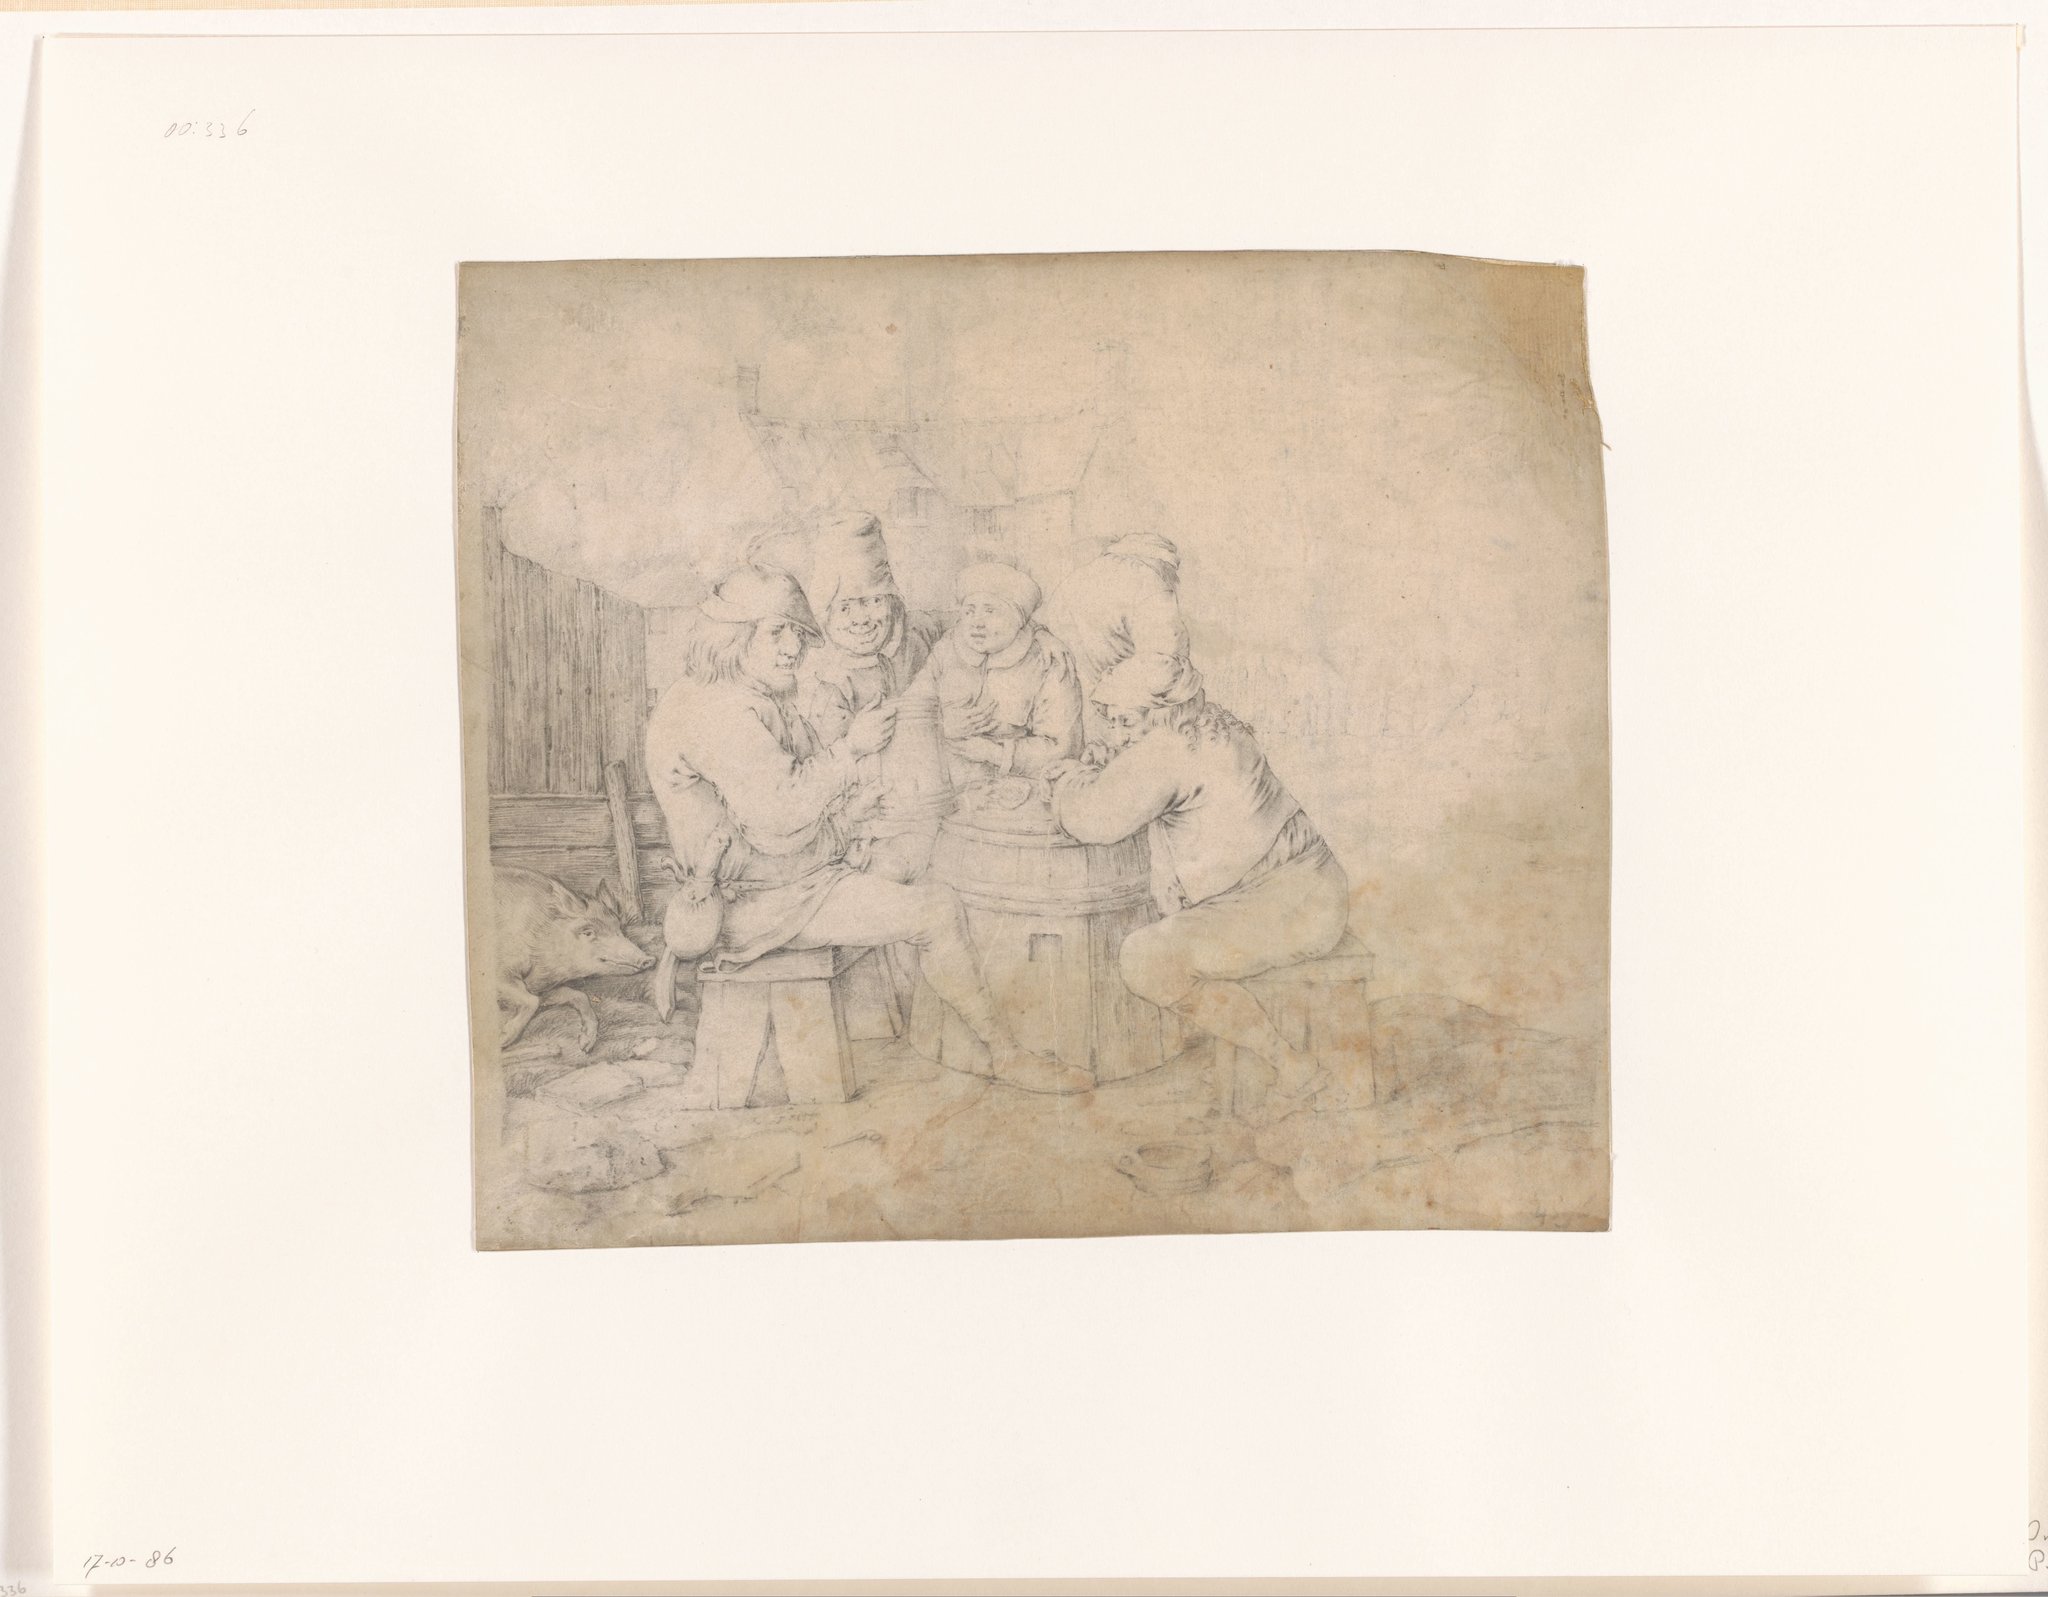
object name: drawing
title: Gezelschap van boeren gezeten rond een ton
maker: cornelis moninckx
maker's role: draughtsman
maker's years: 1623-1666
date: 1633-1666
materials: parchment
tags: farmers, private festivities, merry company - aa - in the open air, 'fête champêtre'